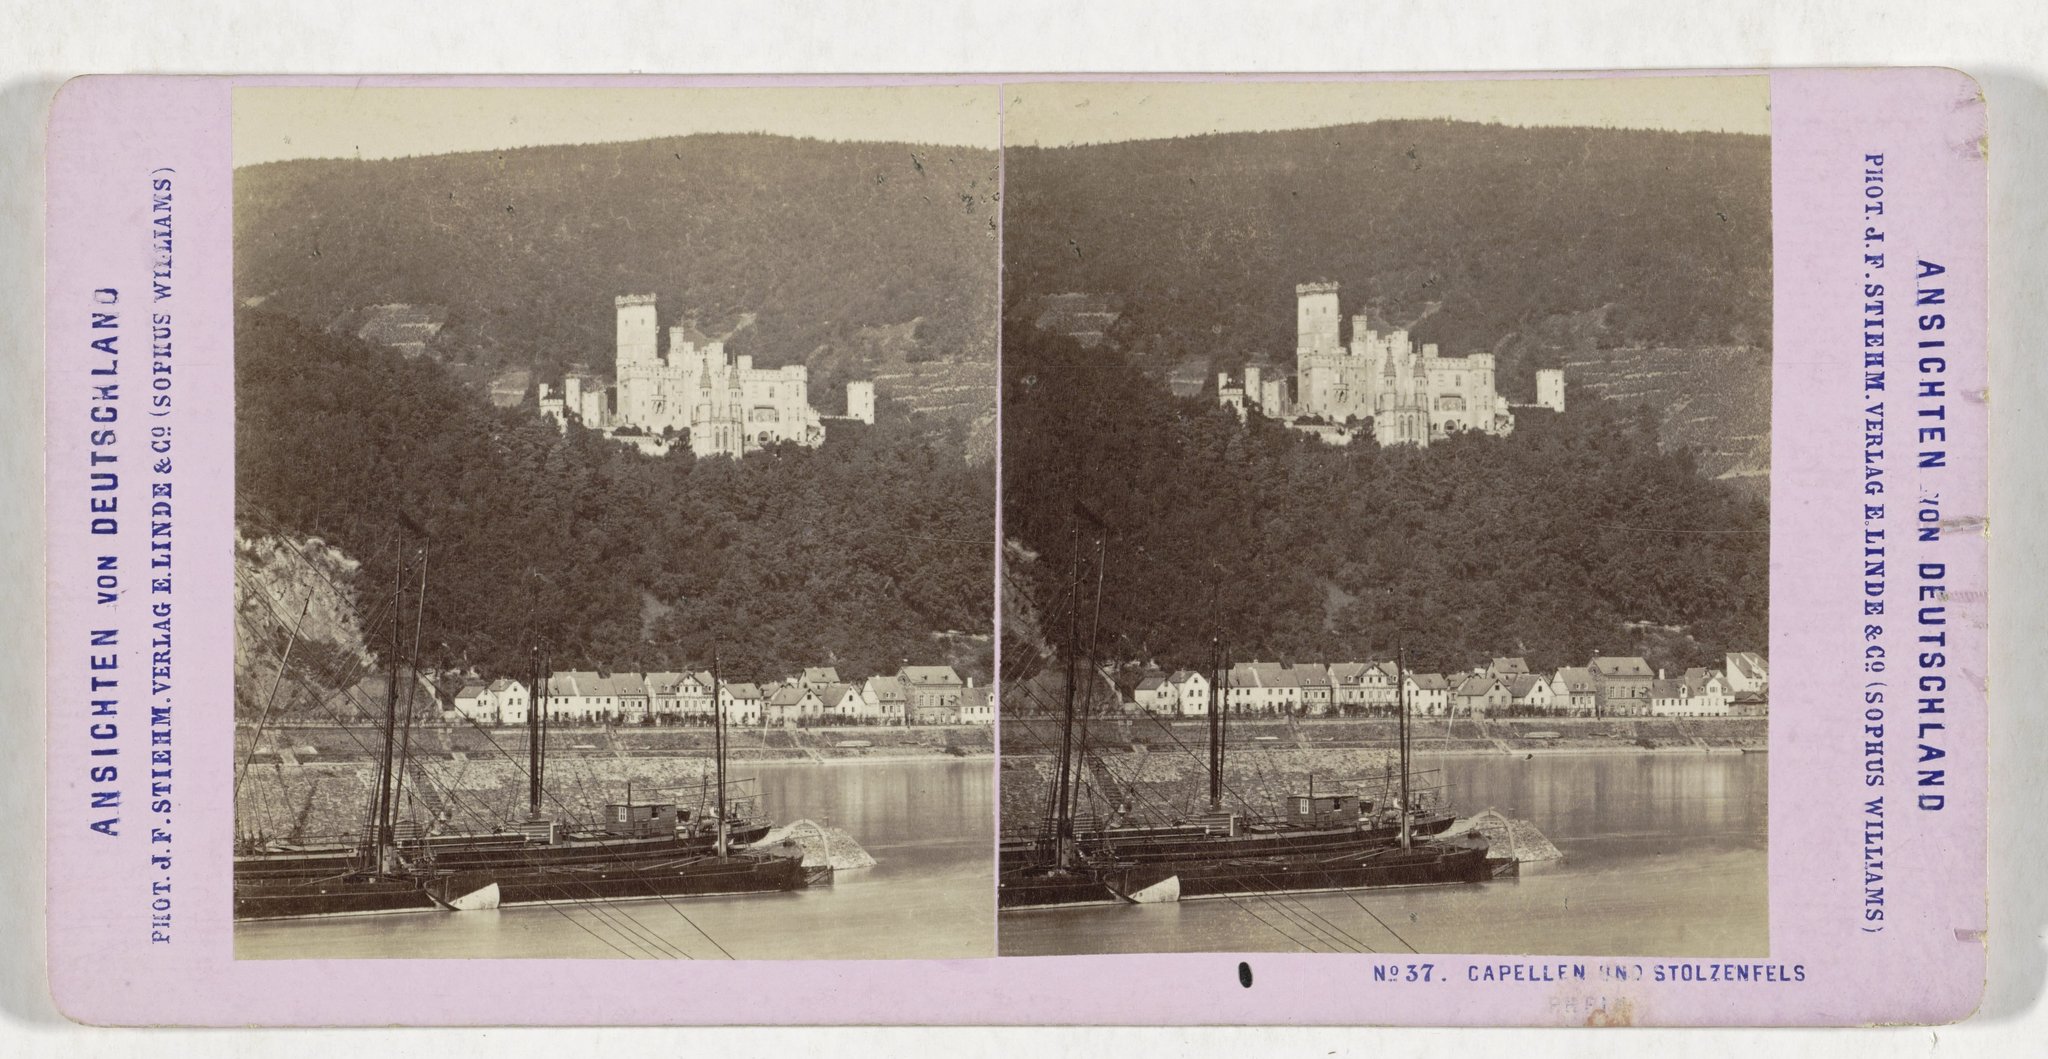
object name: stereograph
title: Ansichten von Deutschland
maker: johann friedrich stiehm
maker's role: fotograaf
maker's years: 1826-1902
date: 1872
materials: cardboard, paper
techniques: albumen print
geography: lahnstein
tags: castle, river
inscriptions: number: ‘No 37.’, date: ‘Di. 13 Augs 1872.’